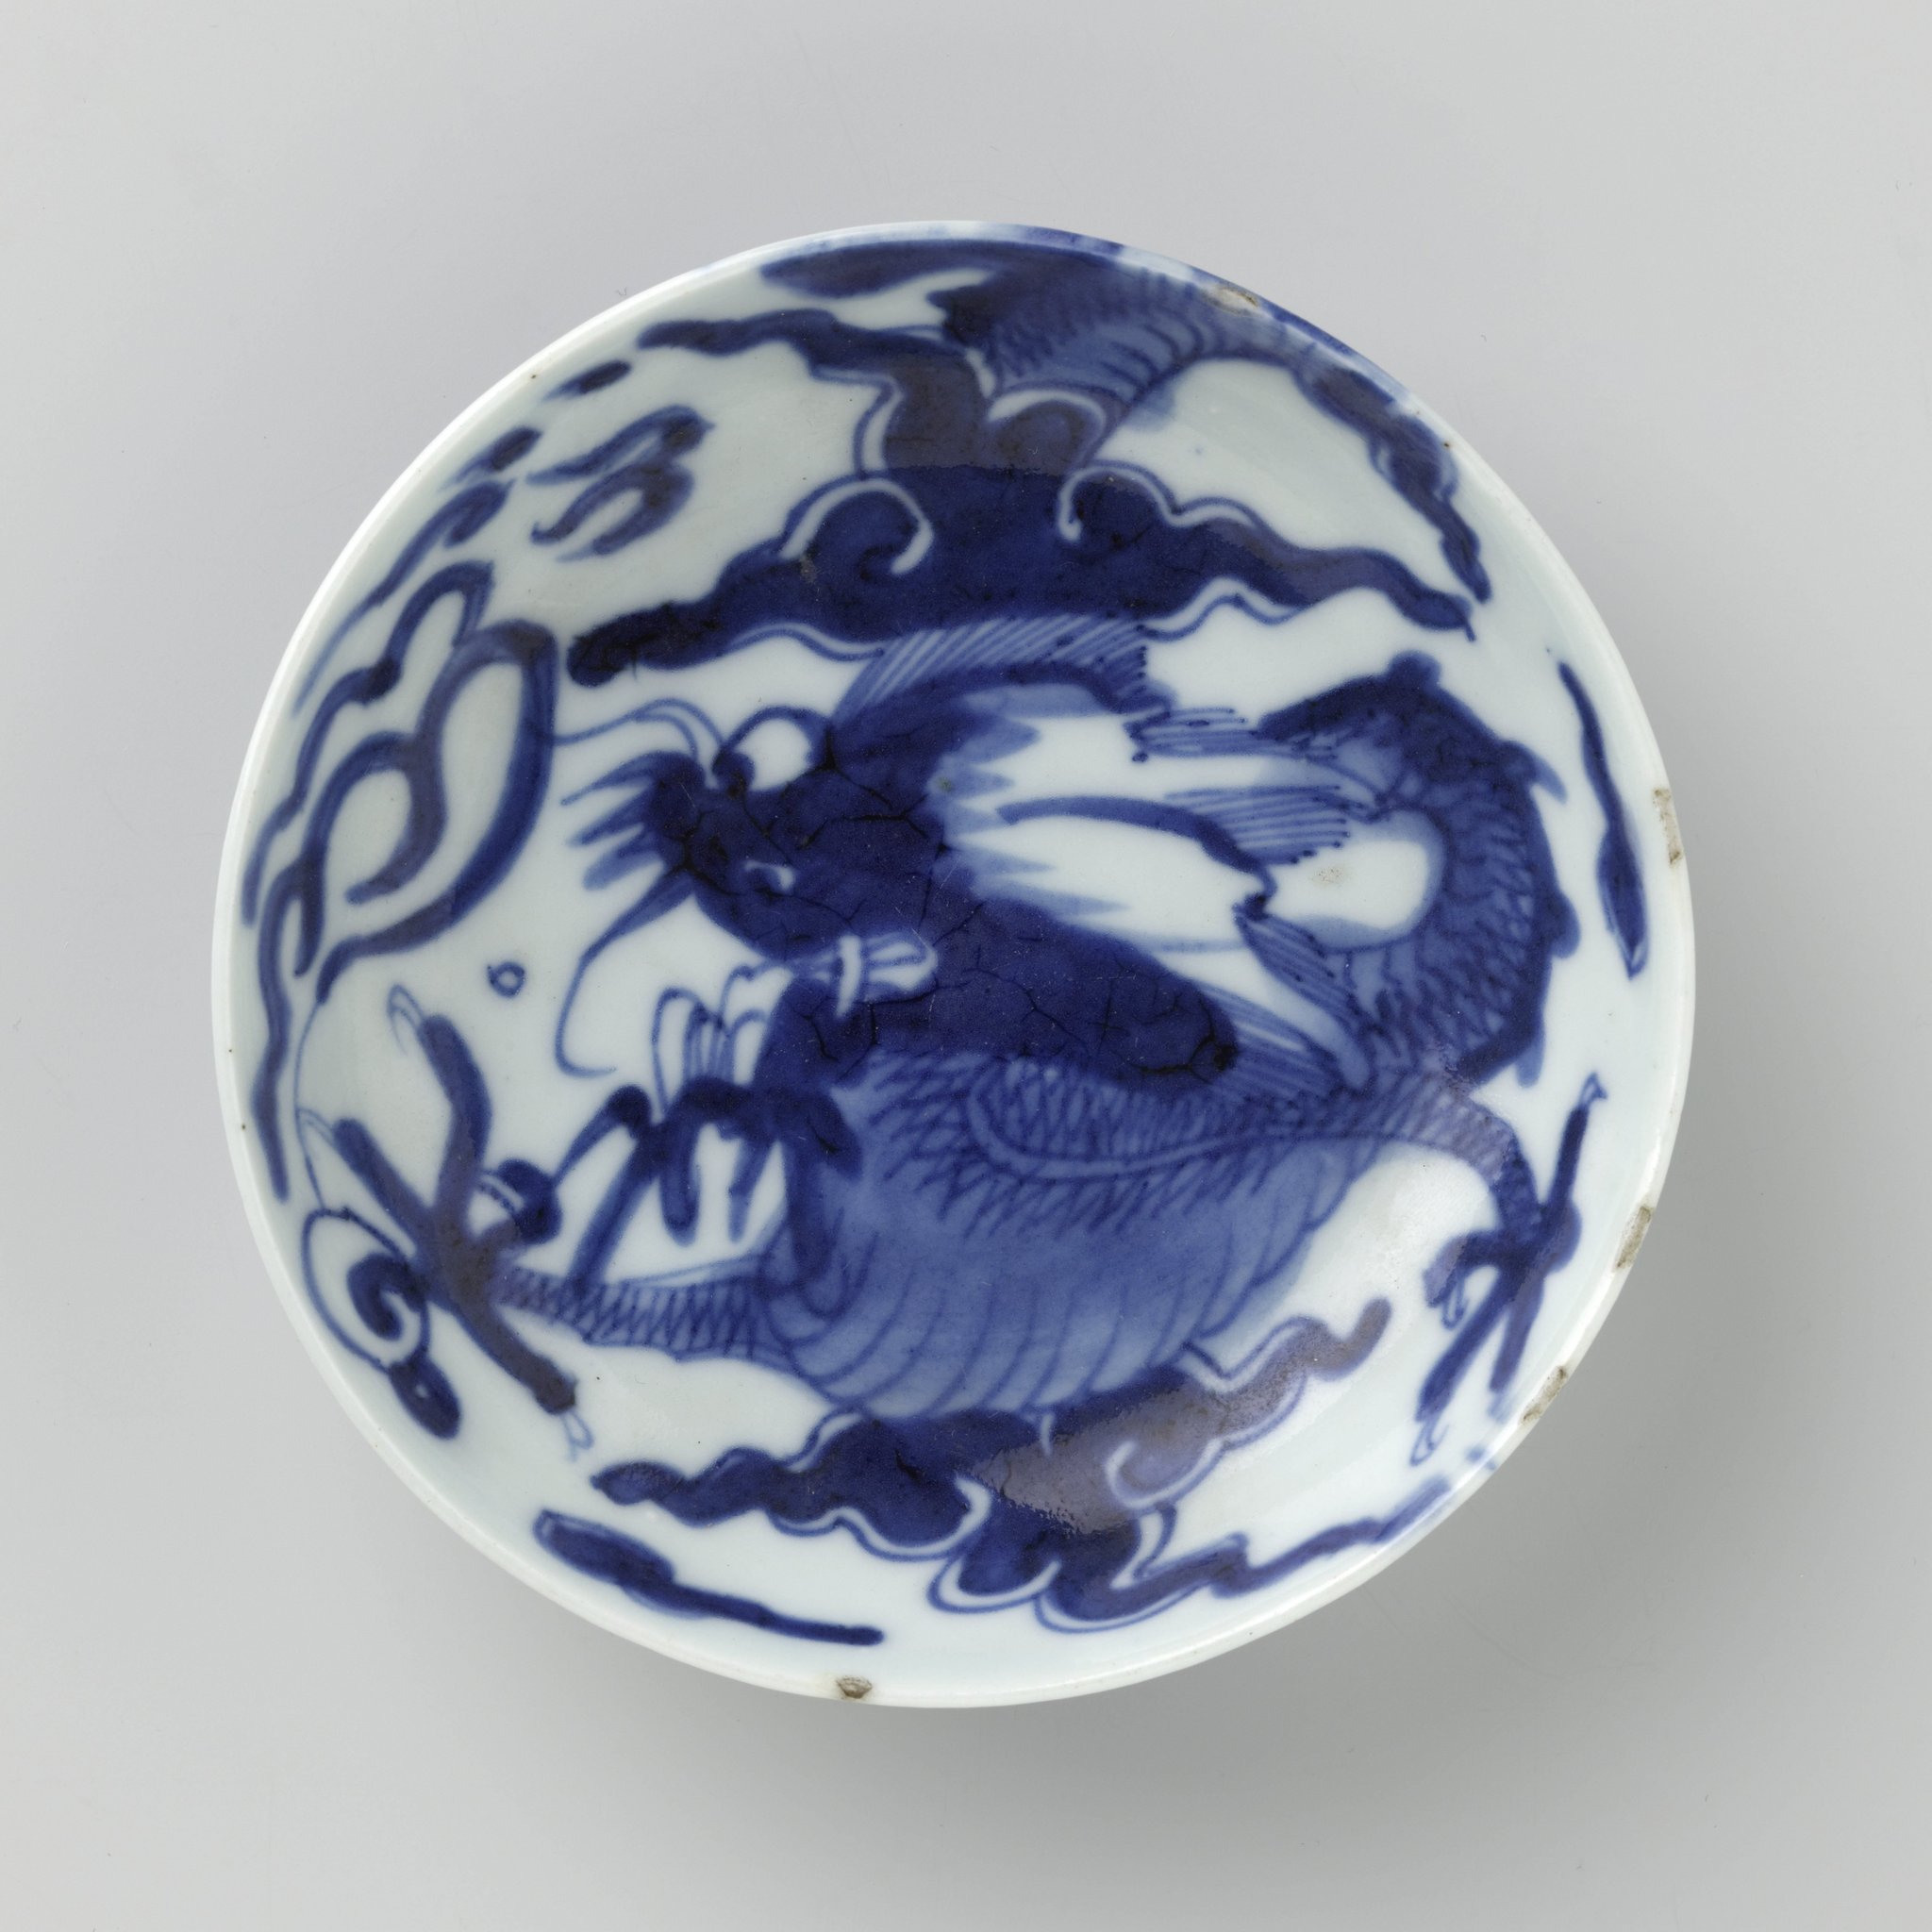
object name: kop en schotel, kop en schotel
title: Saucer with a pearl chasing dragon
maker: Anonymous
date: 1750-1774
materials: cobalt, glaze, paint, porcelain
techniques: firing, turning, vitrification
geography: china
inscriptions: mark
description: Schotel van porselein met iets spreidende wand, beschilderd in onderglazuur blauw. Op de binnen- en buitenzijde een doorlopende vierklauwige draak een parel najagend, de staart aan de buitenzijde en de kop aan de binnenzijde; de draak is omgeven door wolkmotieven. Gemerkt op de onderzijde met een zegelmerk in een dubbele cirkel. Een chip in de rand. Blauw-wit.